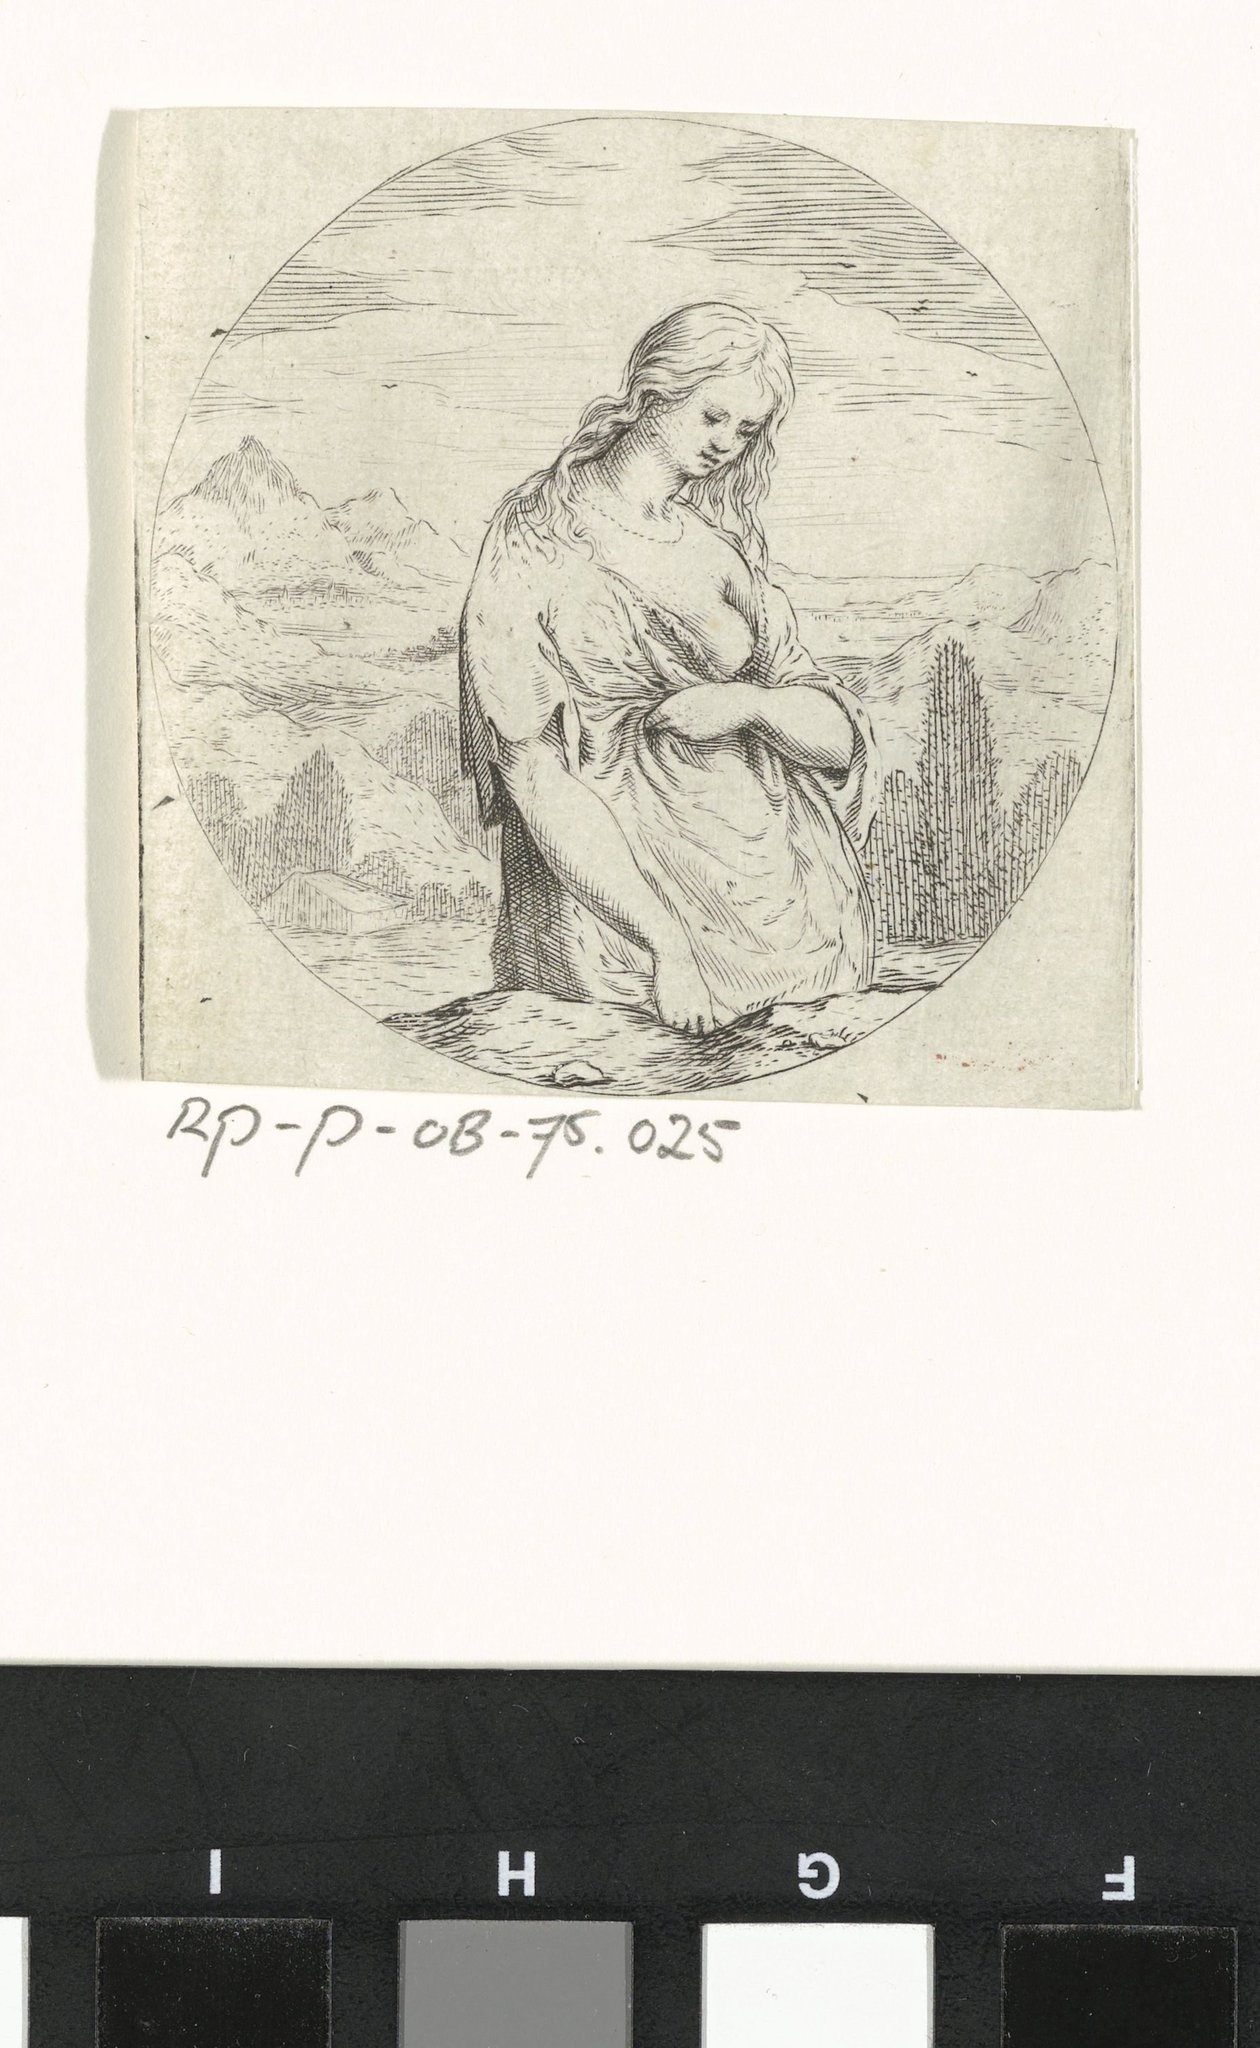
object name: print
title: Vrouw, vermoedelijk Maria Magdalena, staande in landschap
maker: Anonymous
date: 1600-1700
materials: paper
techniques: engraving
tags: the penitent harlot mary magdalene; possible attributes: book (or scroll), crown, crown of thorns, crucifix, jar of ointment, mirror, musical instrument, palm-branch, rosary, scourge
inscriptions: collector's mark: Lugt 240